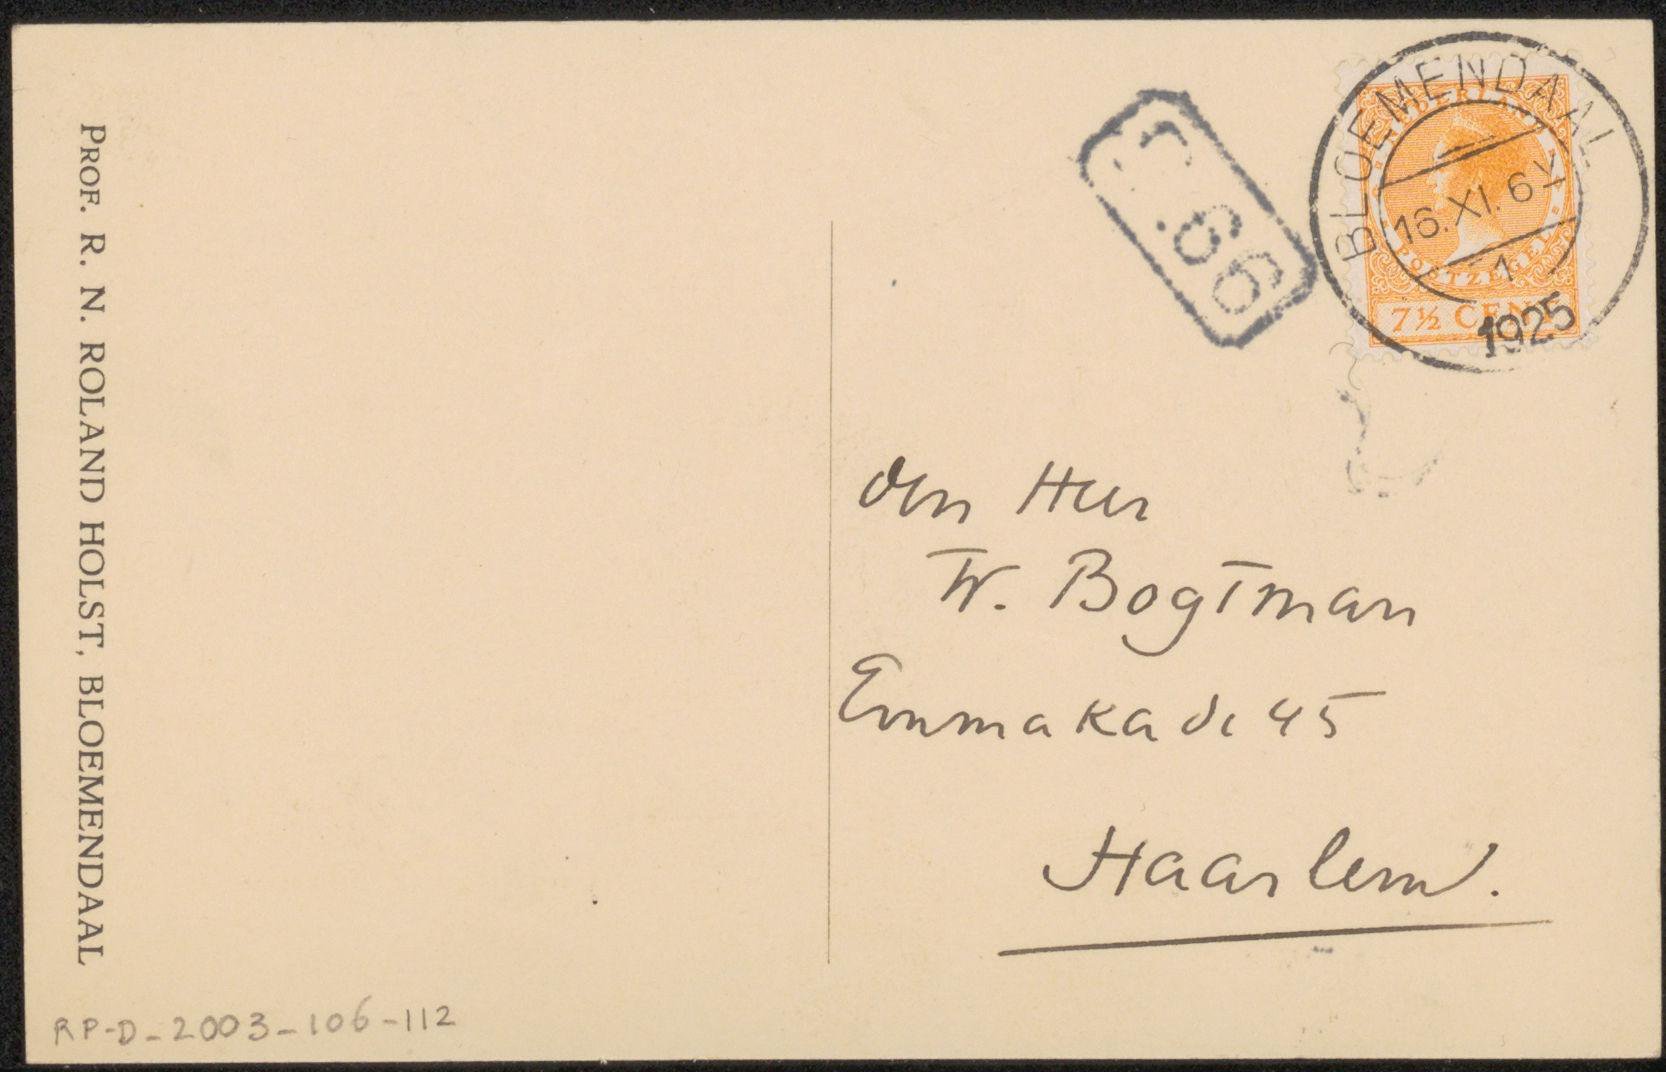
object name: postcard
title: Briefkaart aan Willem Bogtman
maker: richard nicolaüs roland holst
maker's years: 1868-1938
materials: cardboard, ink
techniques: pen, writing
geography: bloemendaal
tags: haarlem, willem bogtman